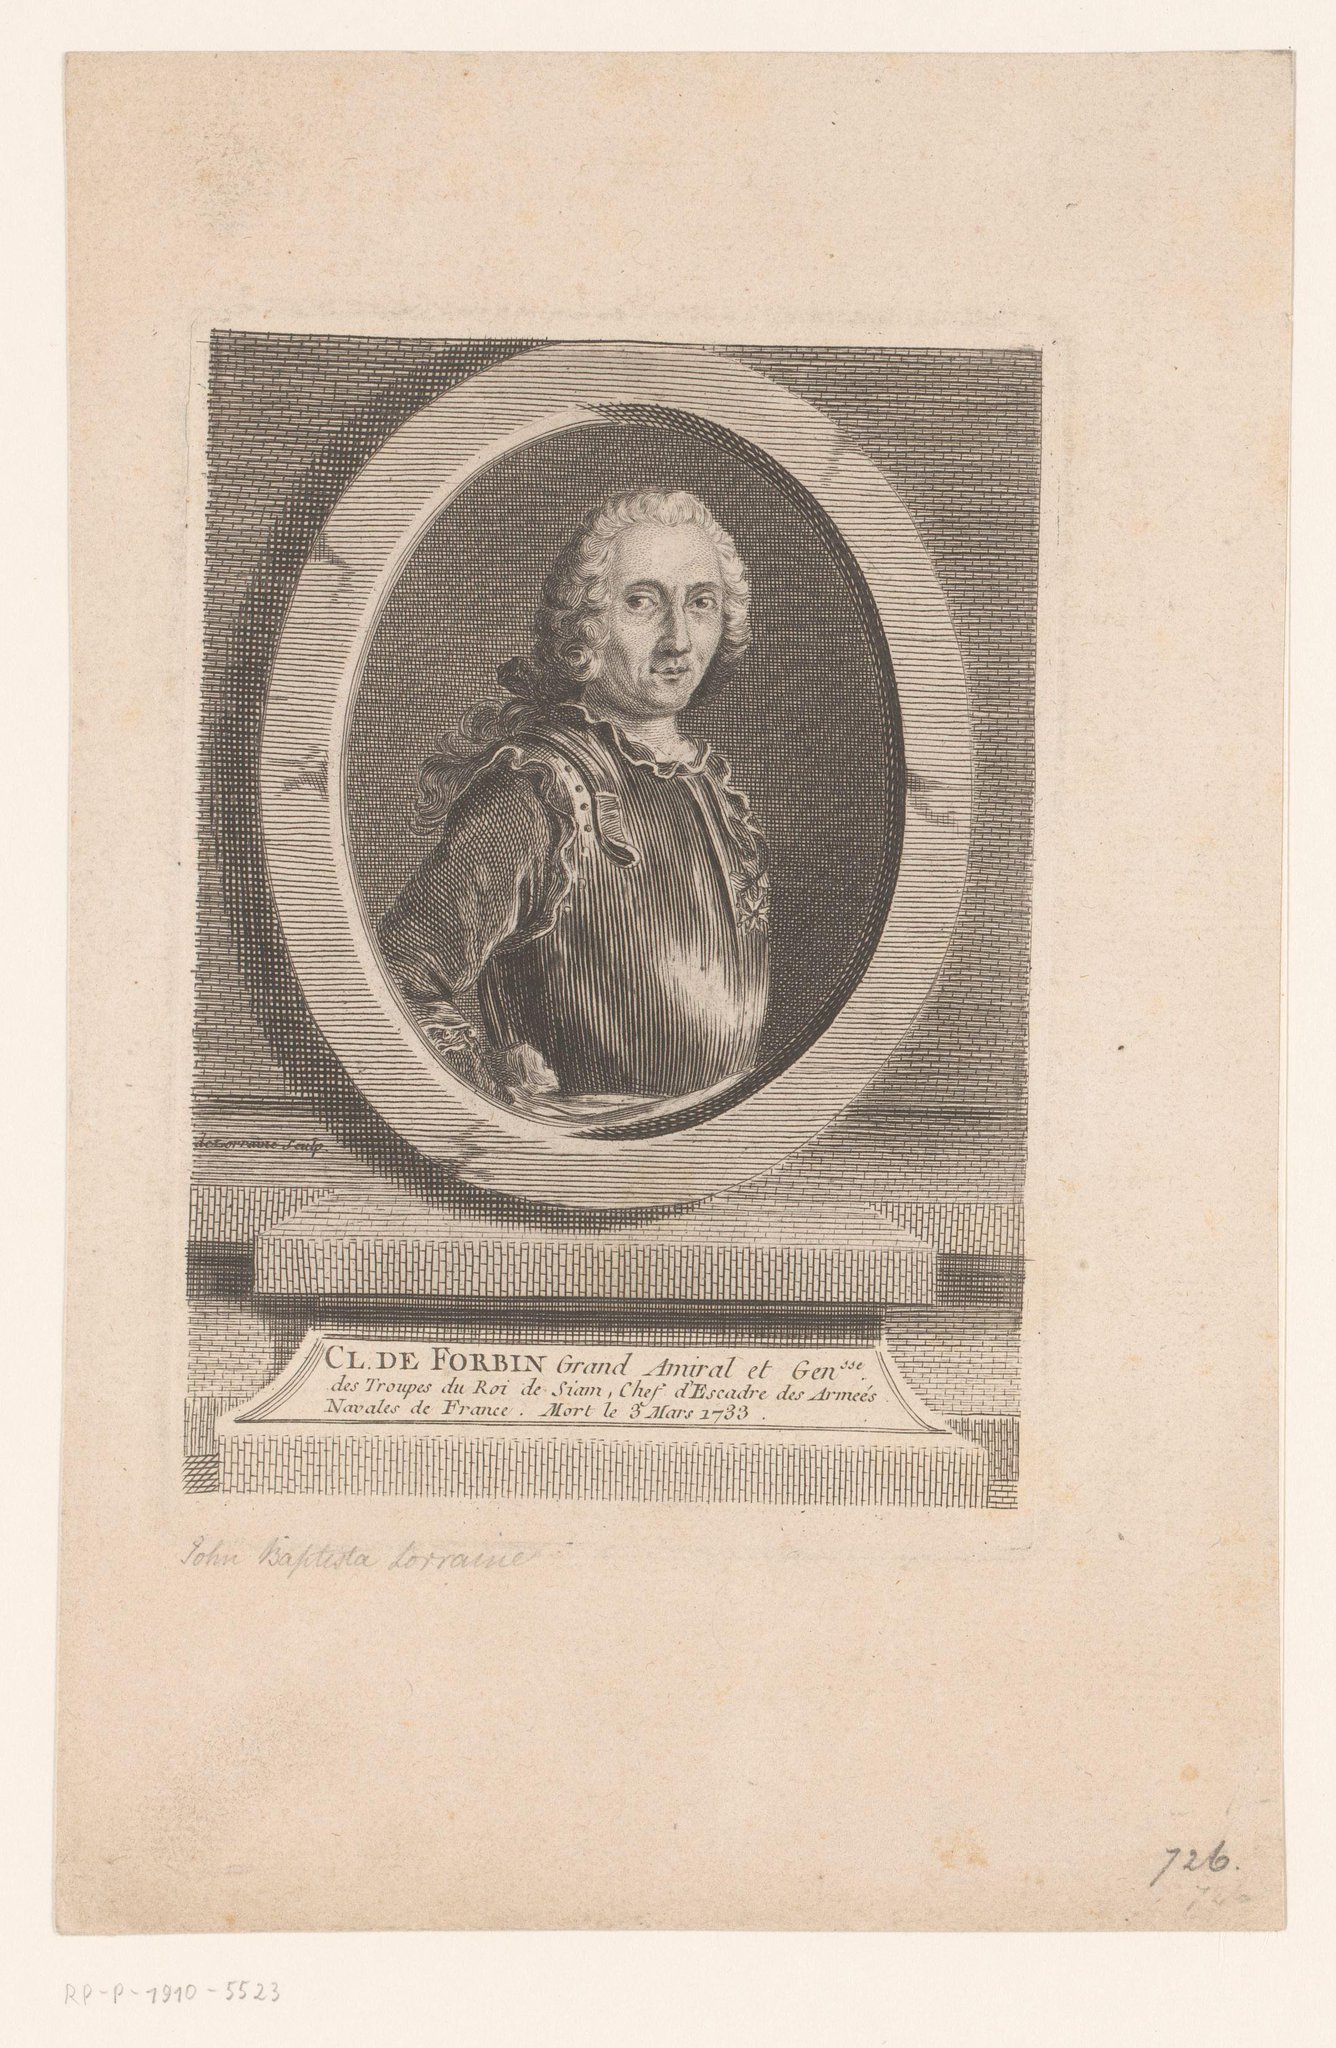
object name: print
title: Portret van Claude de Forbin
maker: jean baptiste de lorraine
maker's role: print maker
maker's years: 1737-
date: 1747-1837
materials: paper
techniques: engraving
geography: france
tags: historical persons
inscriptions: collector's mark: Lugt 2228